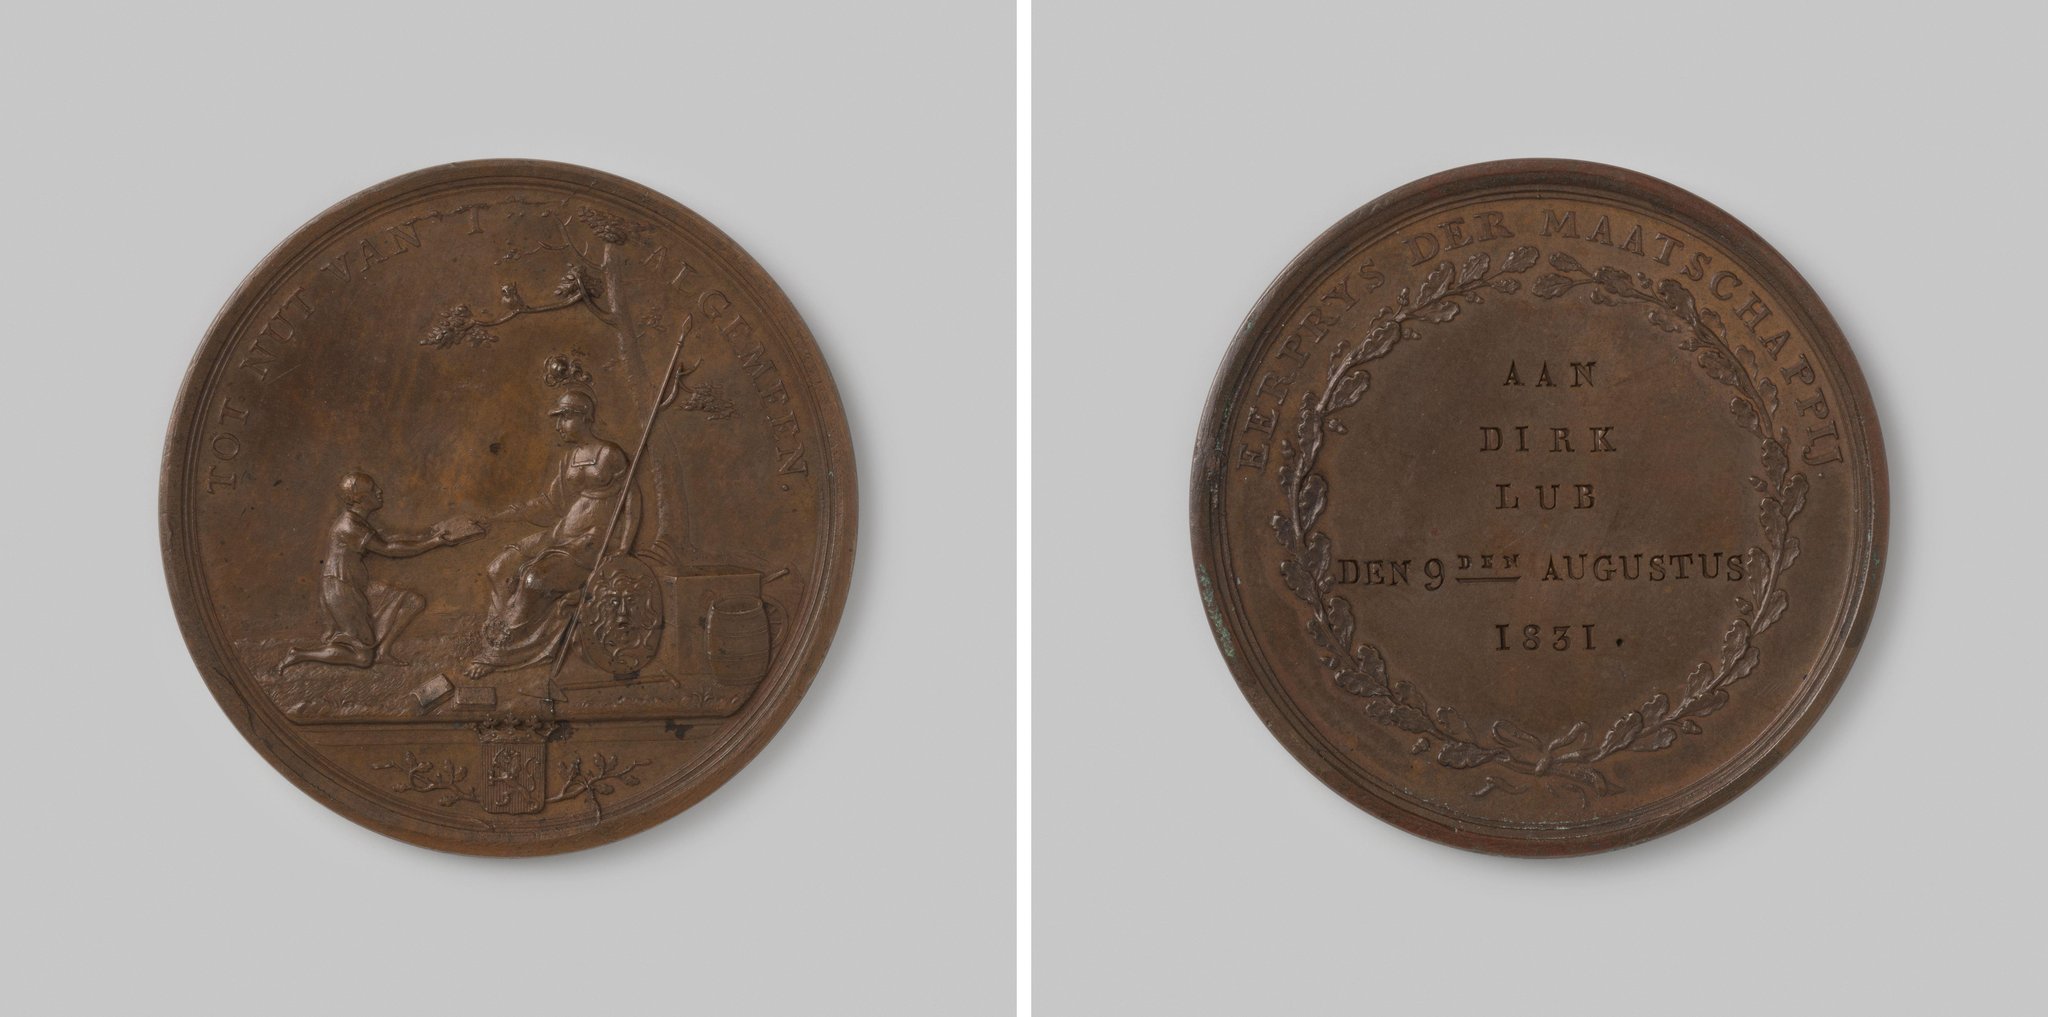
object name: medal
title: Prijspenning van de Maatschappij tot Nut van 't Algemeen op naam van Dirk Lub 1831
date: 1831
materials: copper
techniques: printing, striking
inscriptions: inscription: ‘VOOR EDELMOEDIGE DADEN’, circumscription: ‘EERPRYS DER MAATSCHAPPY’, circumscription: ‘TOT NUT VAN 'T - ALGEMEEN’, inscription: ‘AAN / DIRK / LUB / DEN 9den AUGUSTUS / 1831.’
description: Bronzen penning, op de voorzijde Minerva onder een boom die een boek overhandigt aan een jongeling, met omschrift, in afsnede een gekroond wapenschildje van de Generaliteit op eikentakken, op de keerzijde een inscriptieruimte tussen samengestrikte eikentakken, met omschrift, met randinscriptie VOOR EDELMOEDIGE DADEN.